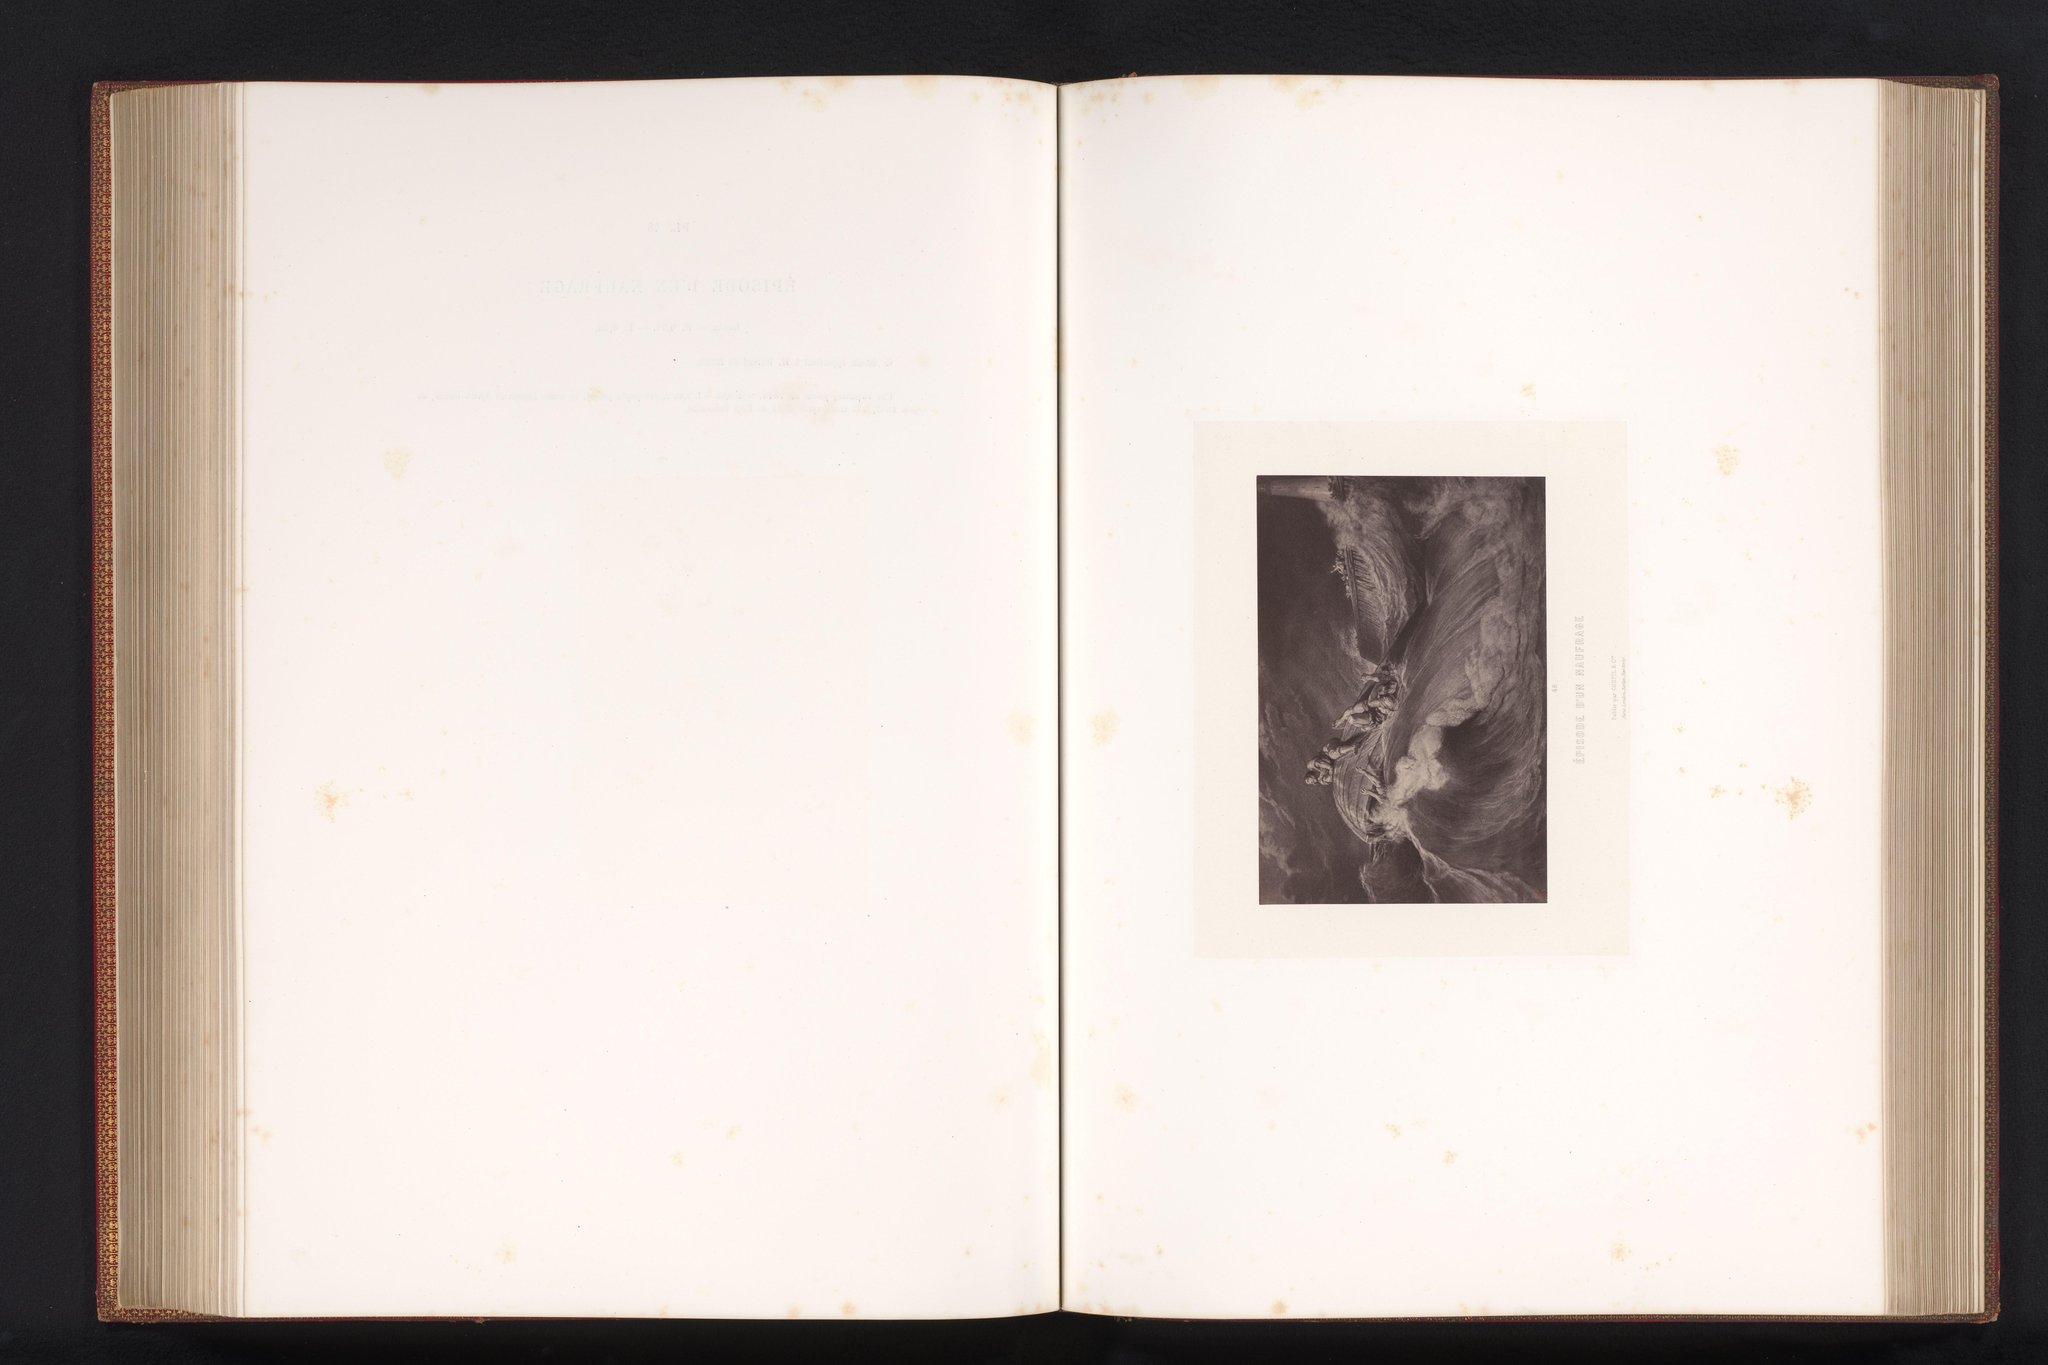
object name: page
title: Fotoreproductie van een tekening van een schipbreuk door Paul Delaroche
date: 1853-1858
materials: paper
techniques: albumen print, engraving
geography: paris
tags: shipwreck, storm at sea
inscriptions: initials: ‘GC’